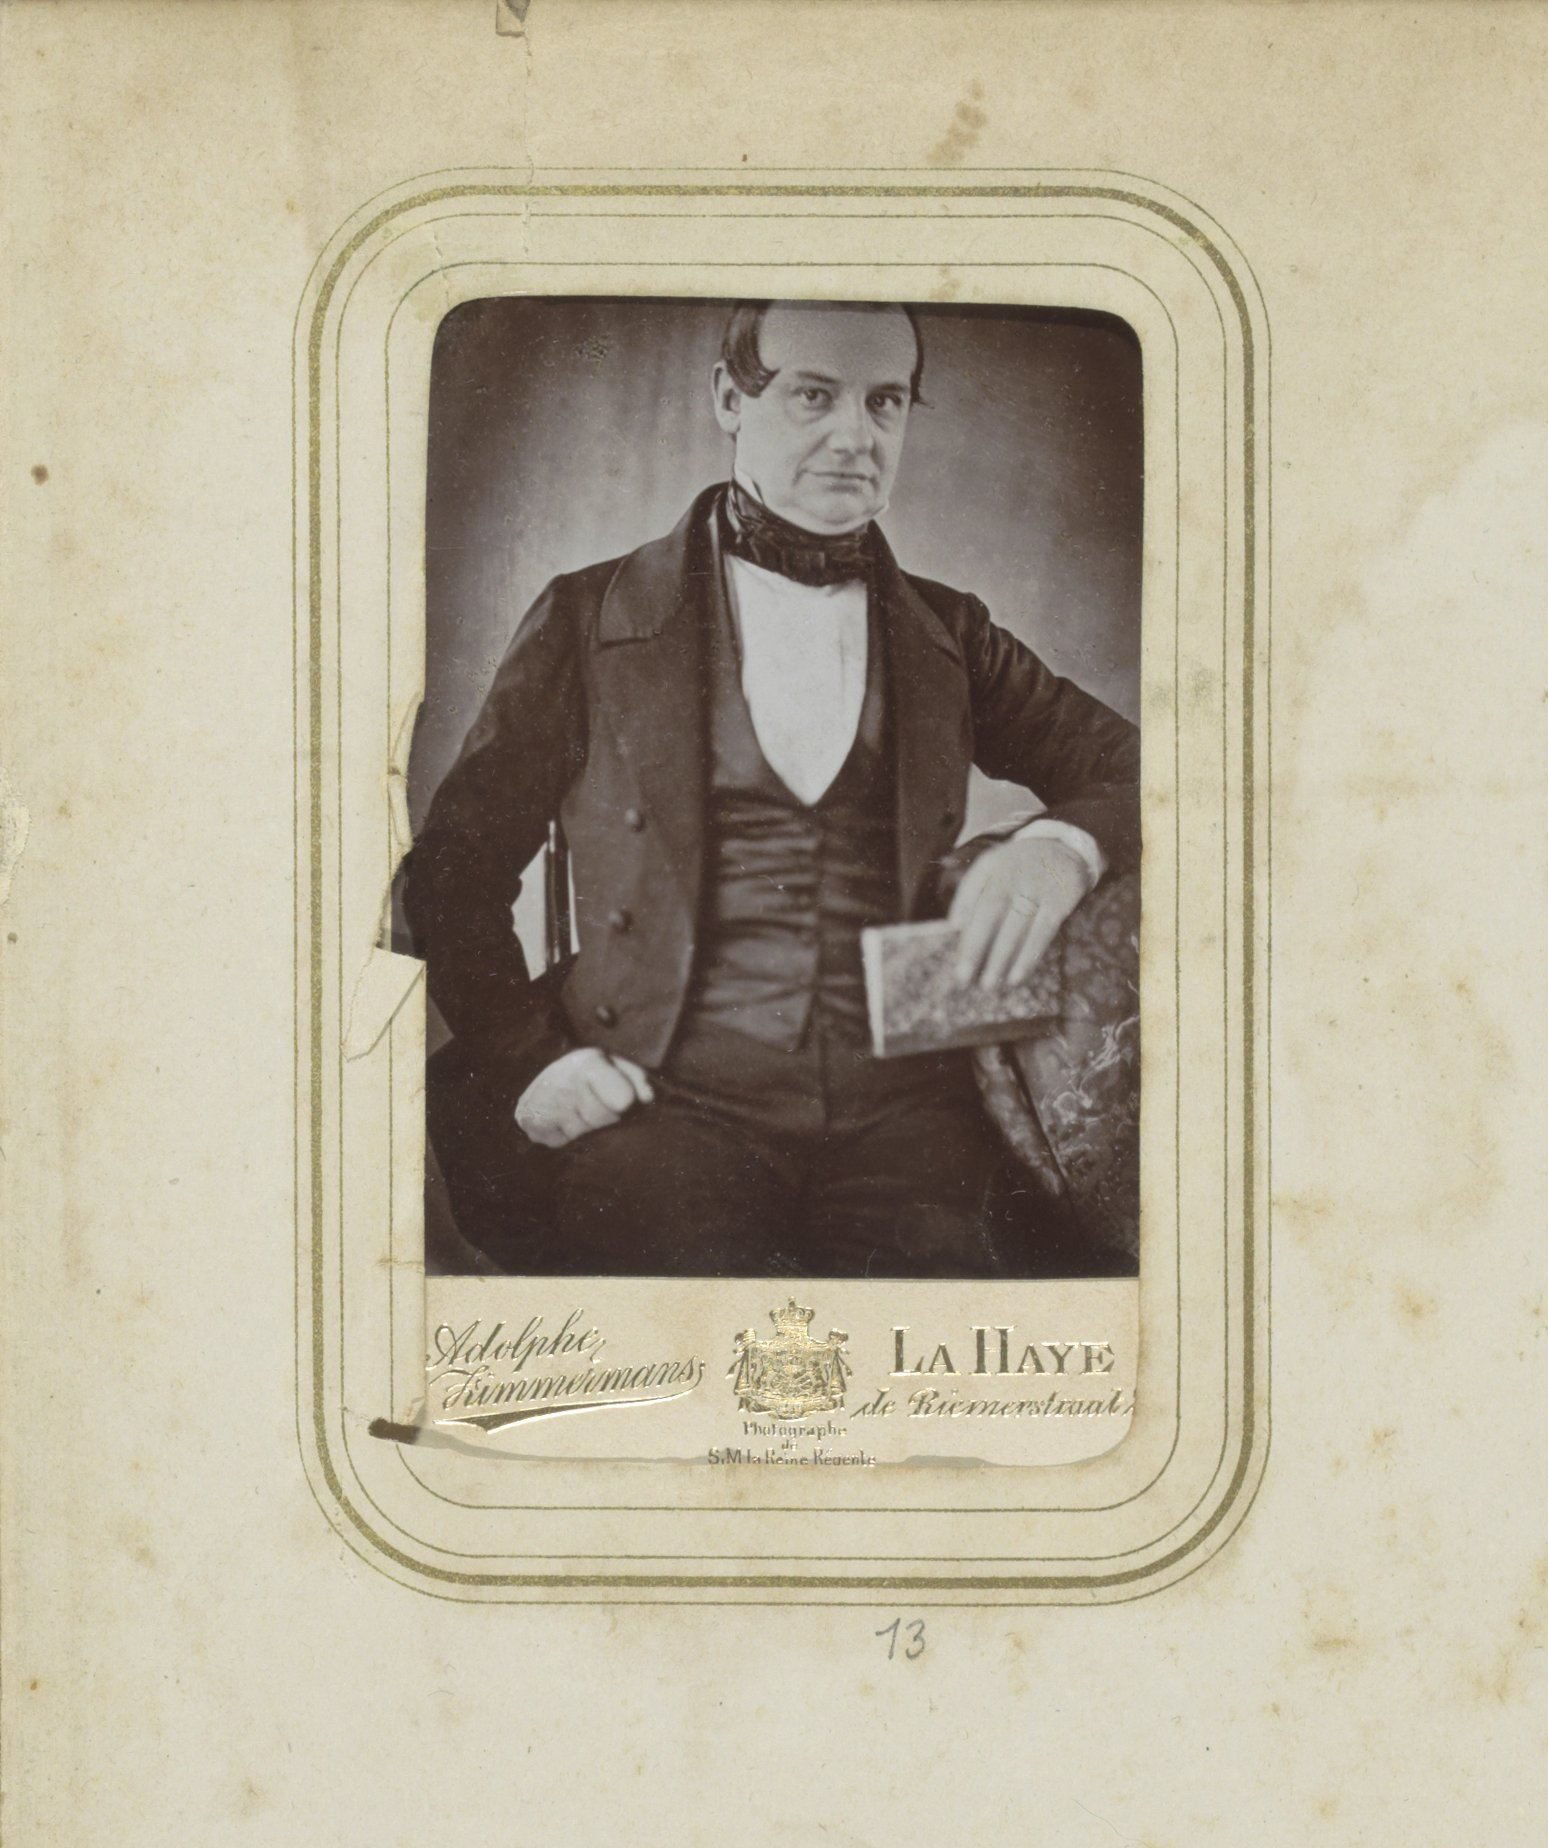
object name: carte de visite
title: Portret van A.J. Swart met een boek in de hand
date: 1913-1922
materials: cardboard, photographic support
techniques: daylight paper print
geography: the hague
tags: amsterdam, studio requisites ~ photographer, clothing for the lower part of the body, historical persons, neck-gear ~ clothing, clothing for the upper part of the body, family, relationship, descent, book, hairdress, the hague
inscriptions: address: ‘De Riemerstraat 21 La Haye’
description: Onderdeel van Familiealbum van H.W.F. Ligtenberg en L.M. Swart met 149 foto's en cartes-de-visite.